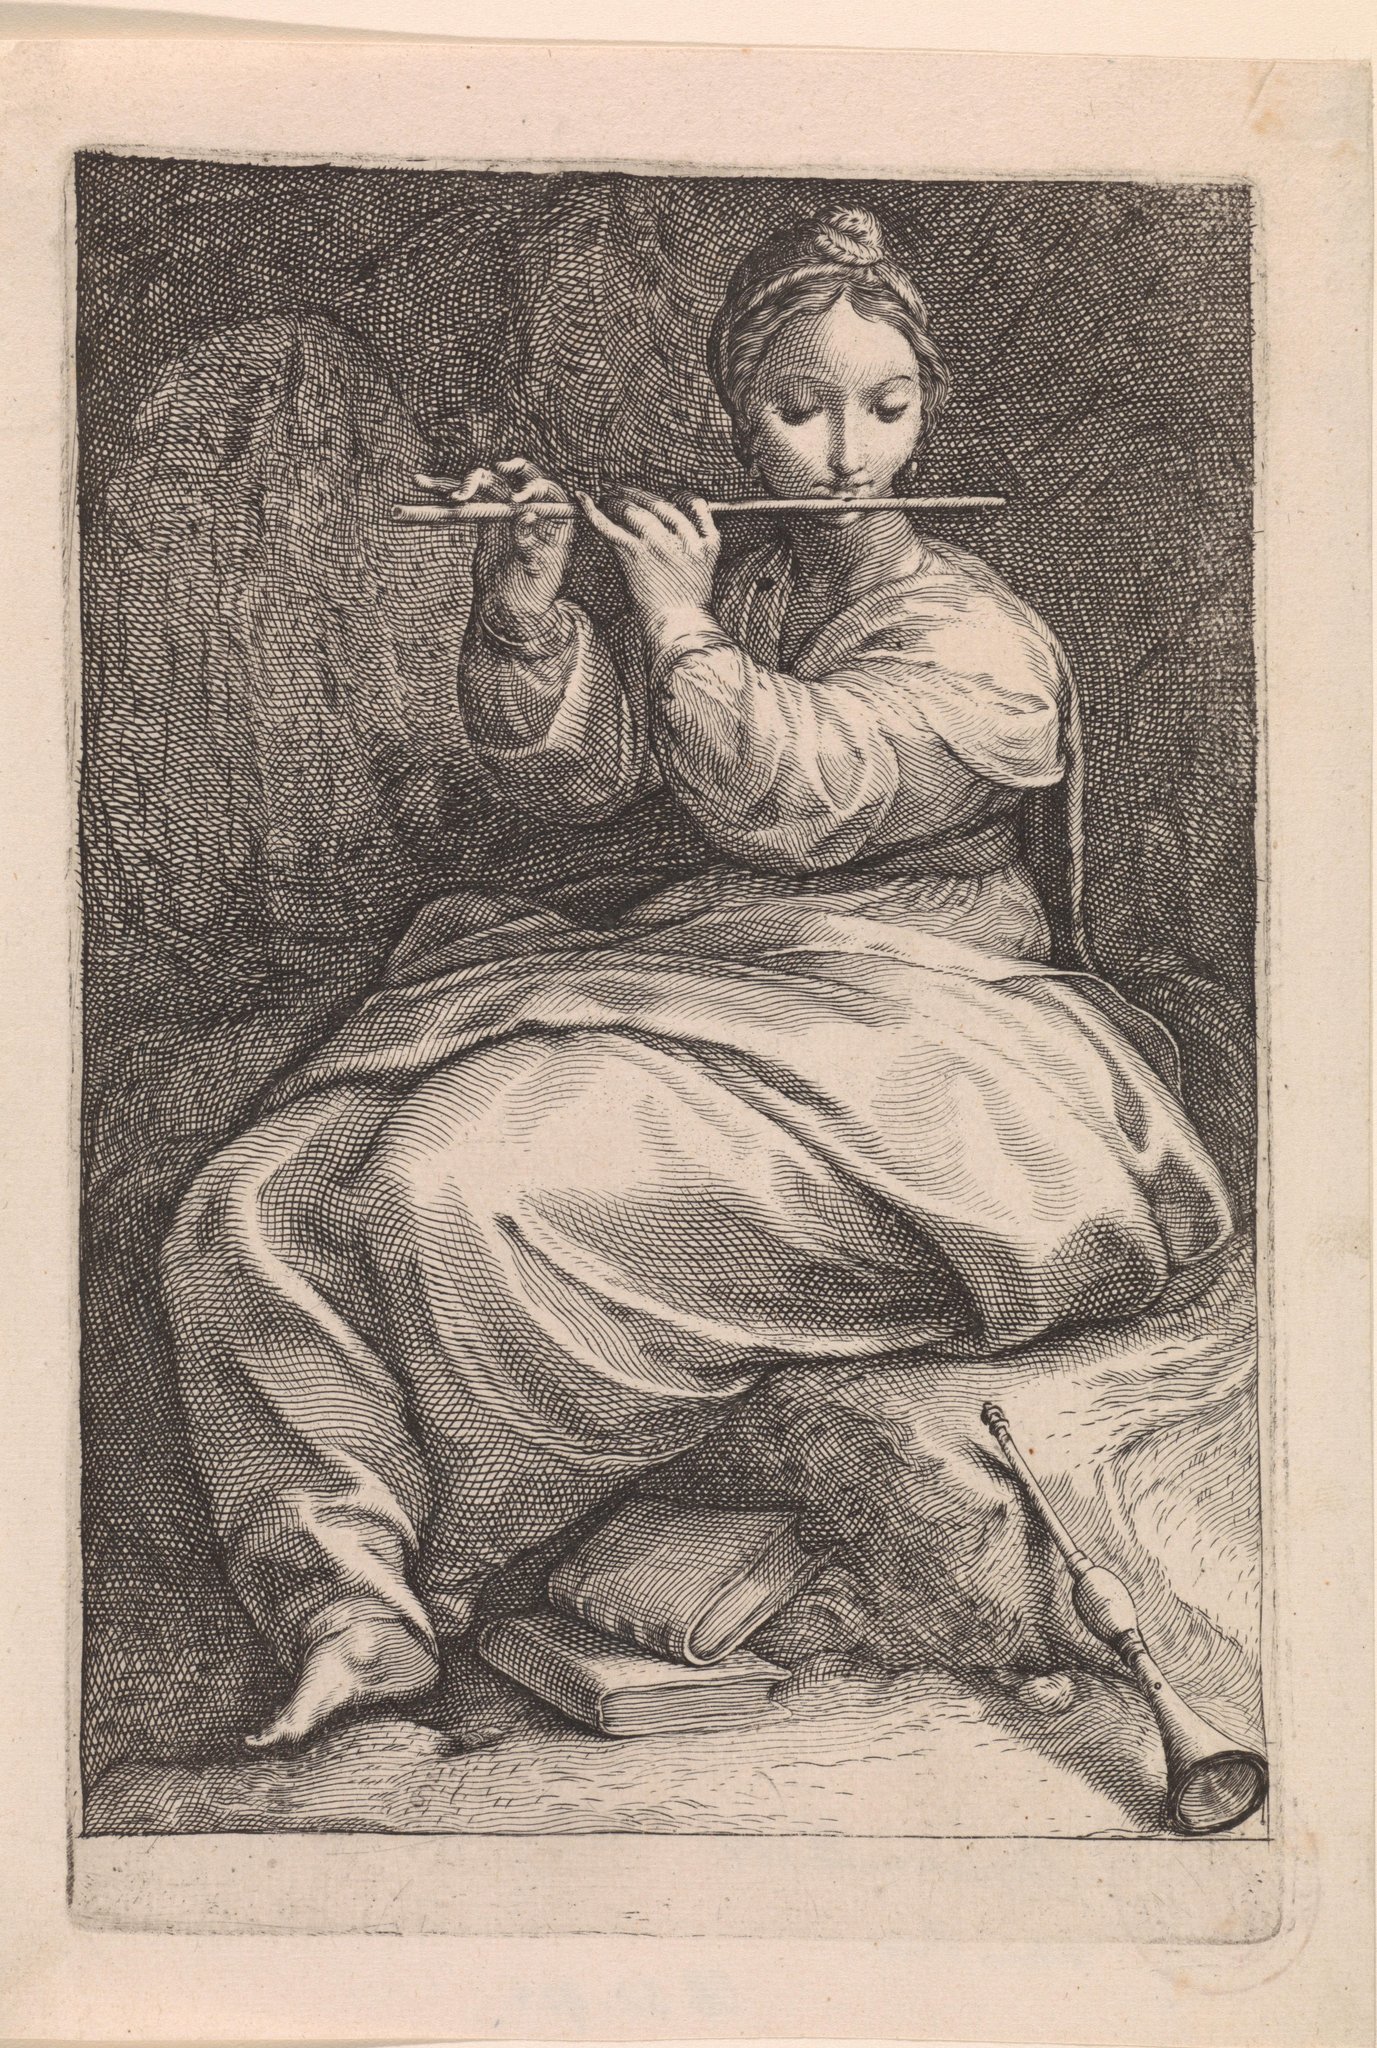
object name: print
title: De negen muzen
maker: Anonymous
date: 1592-1667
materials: paper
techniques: drypoint, engraving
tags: euterpe (one of the muses); 'euterpe' (ripa)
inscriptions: collector's mark: Lugt 240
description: De zittende Euterpe, de muze van de muziek en lyriek, bespeelt de dwarsfluit en aan haar voeten liggen een klarinet en boeken.